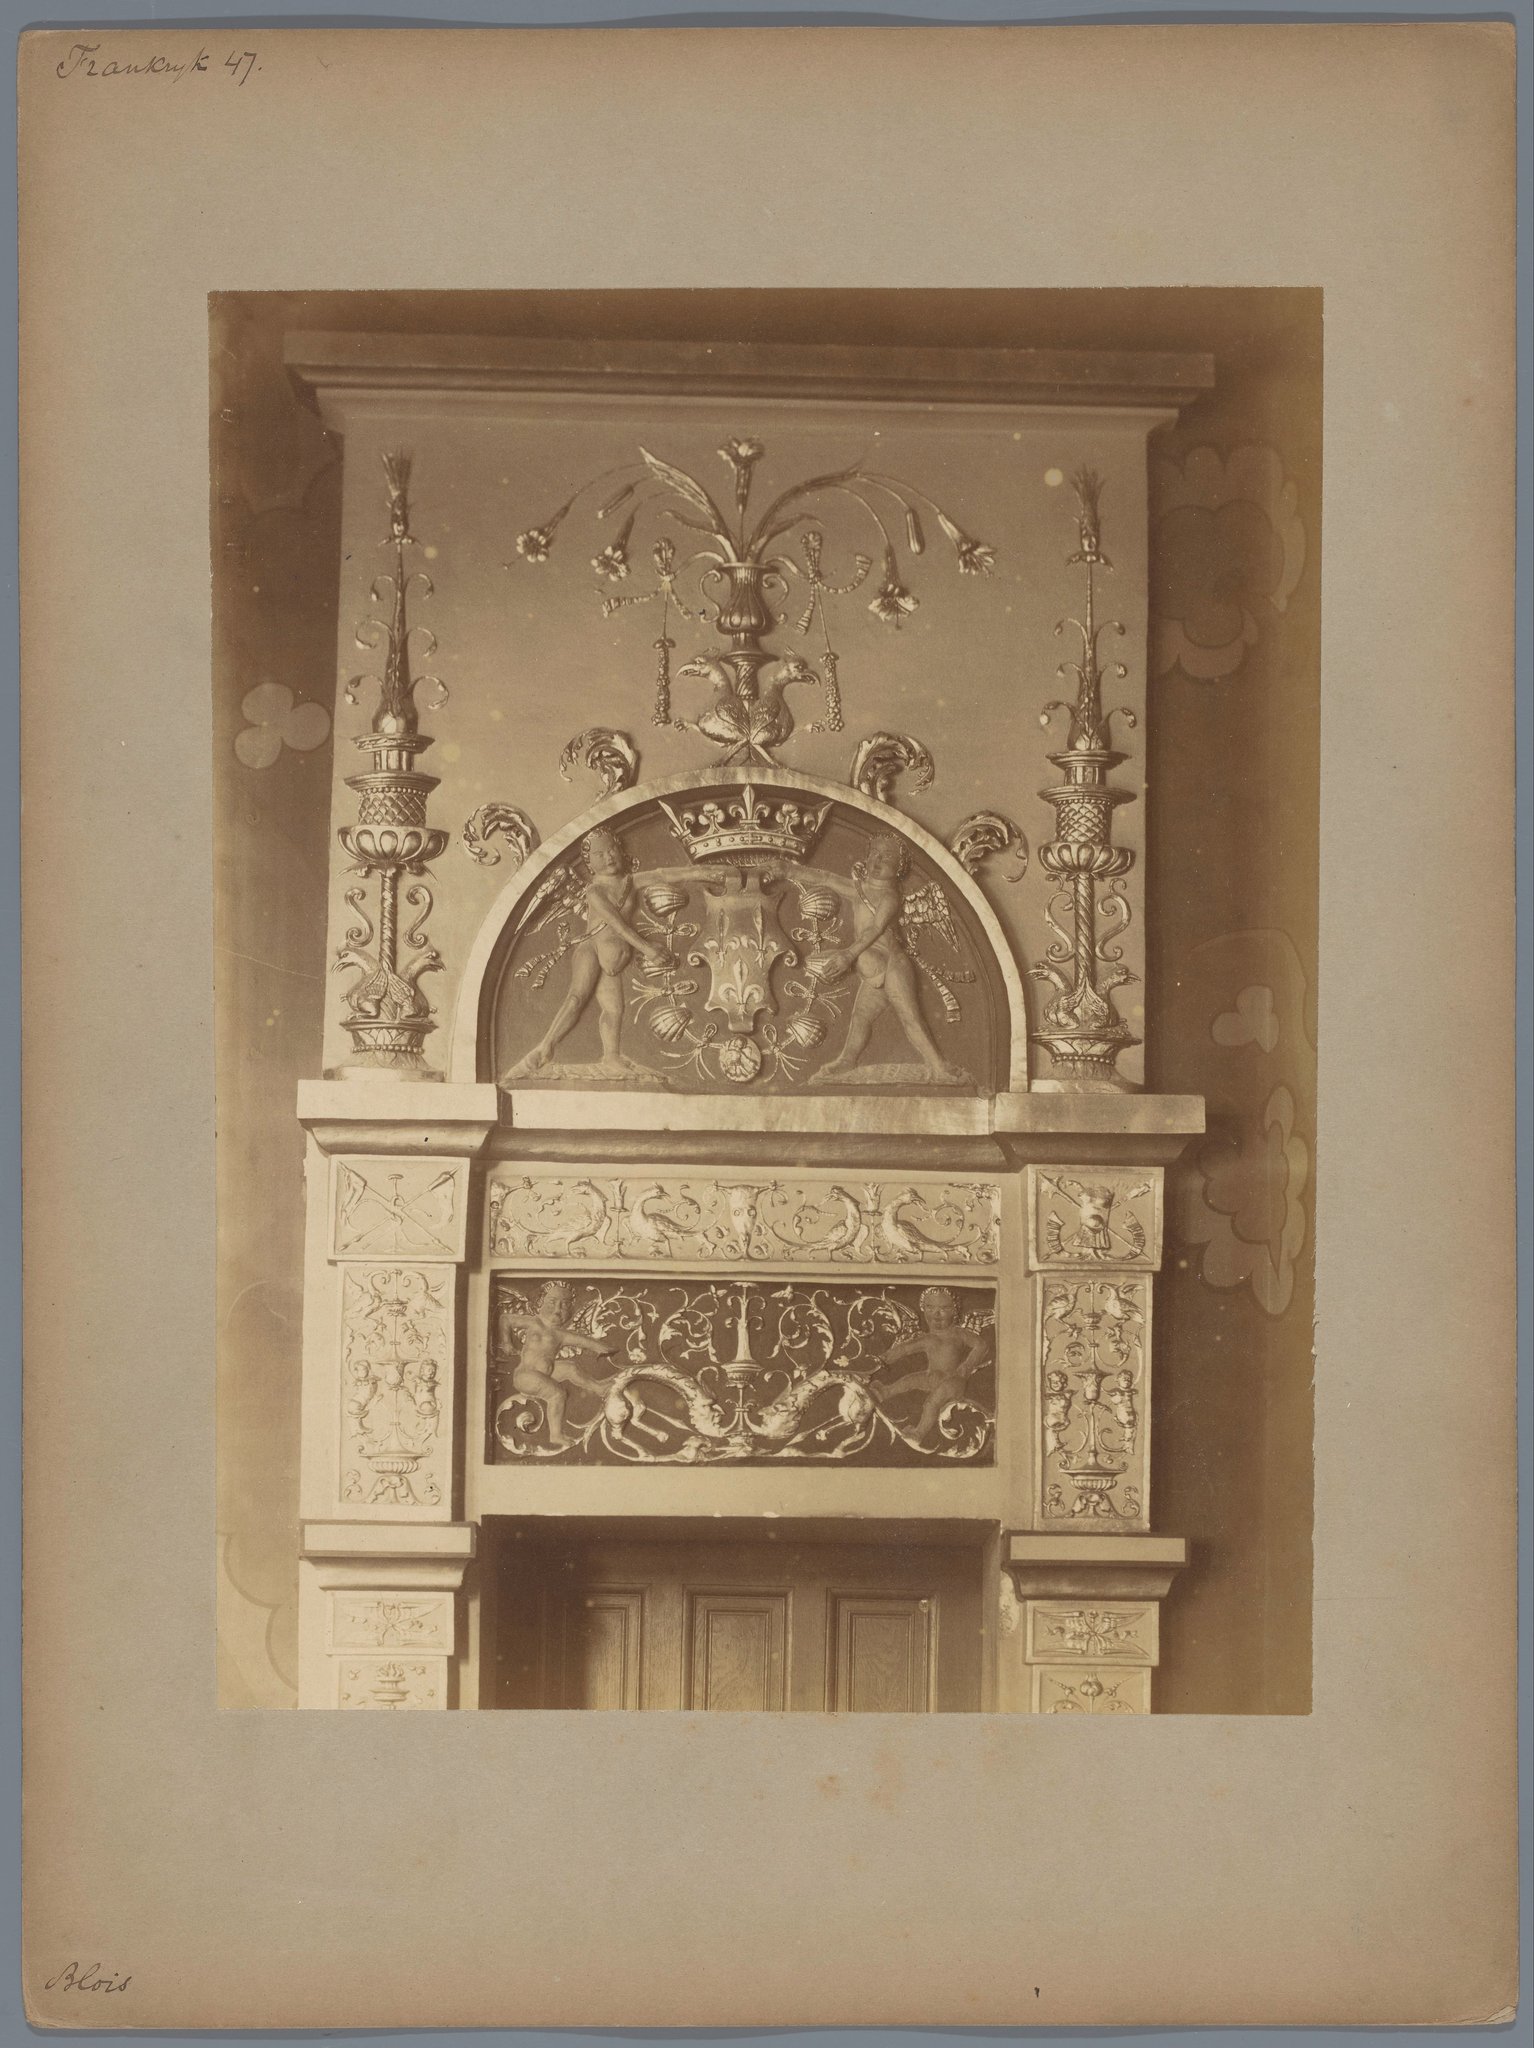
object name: photograph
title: Deur in het kasteel van Blois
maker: b. f. rives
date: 1850-1900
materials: cardboard, photographic support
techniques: albumen print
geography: blois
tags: door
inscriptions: annotation: ‘Blois’, check stamp: ‘B. F. K. Rives No. 74’, collector's mark: ‘RIJKS [NORMAAL]SCHOOL voor T[EEKENONDERWIJZERS] AMSTERDAM’, annotation: ‘Blois’, annotation: ‘Frankrijk 47.’